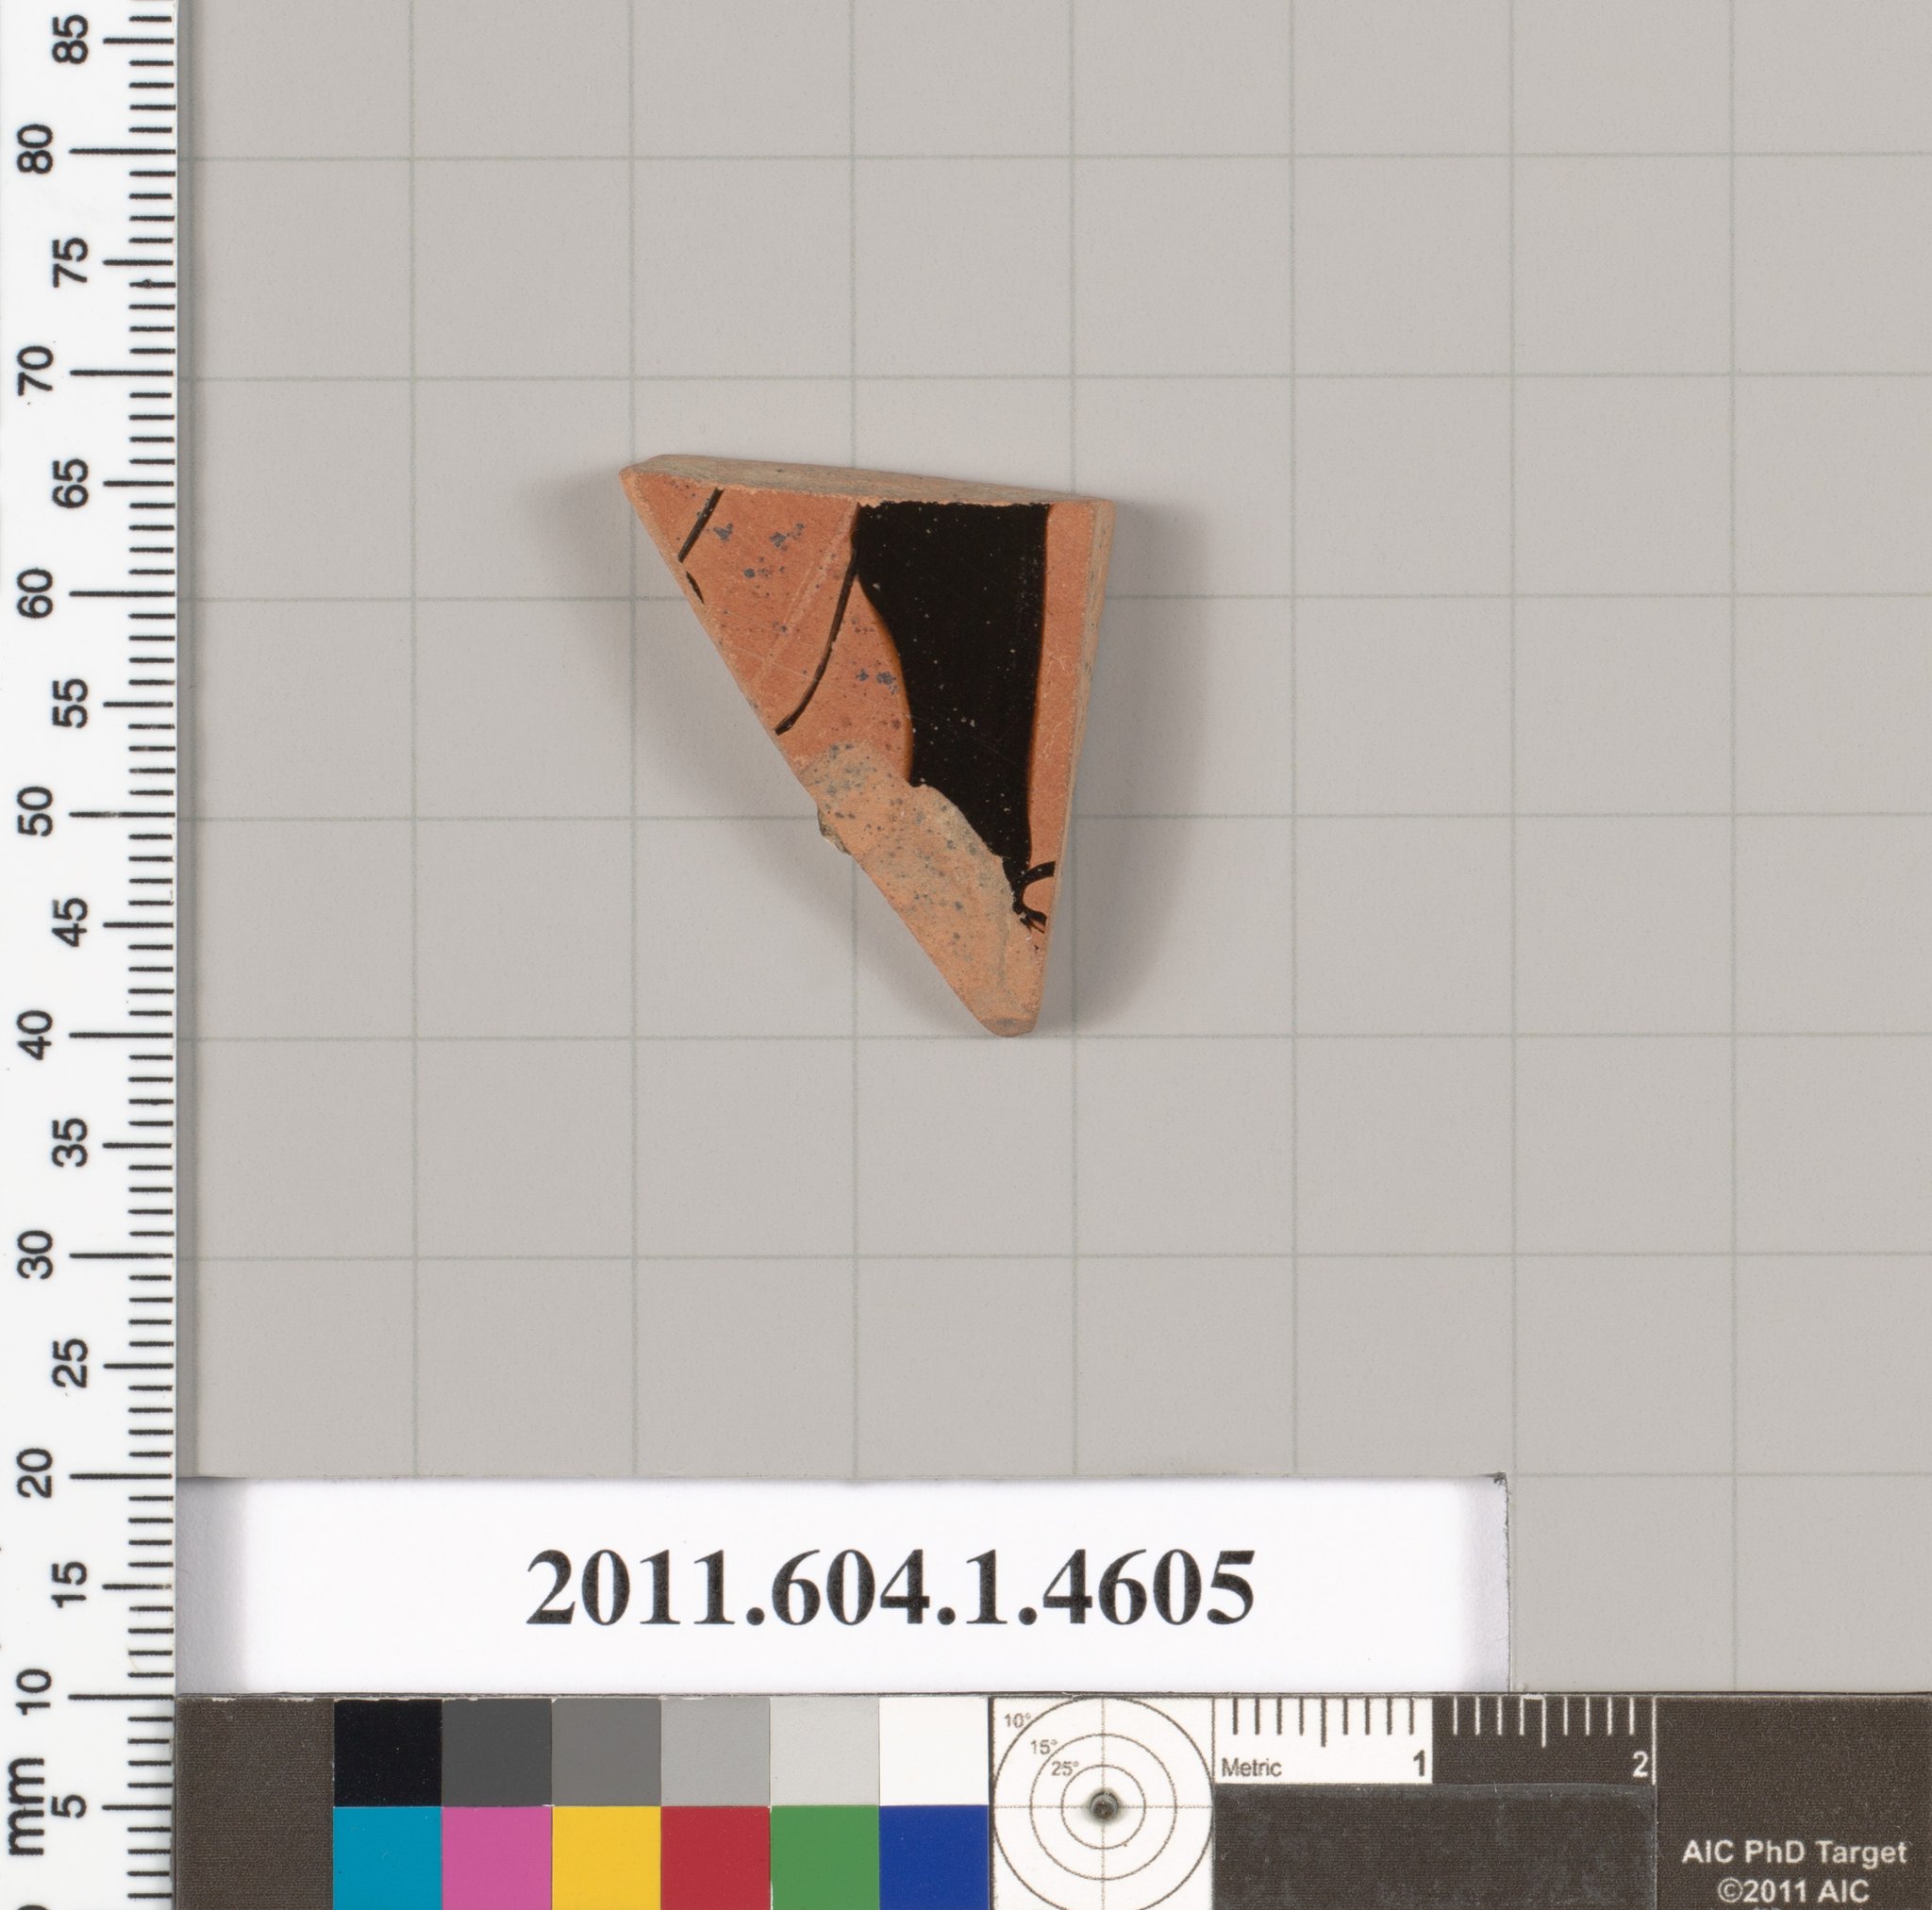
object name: kylix fragment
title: Terracotta fragment of a kylix (drinking cup)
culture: greek, attic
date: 490-470 BCE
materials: terracotta